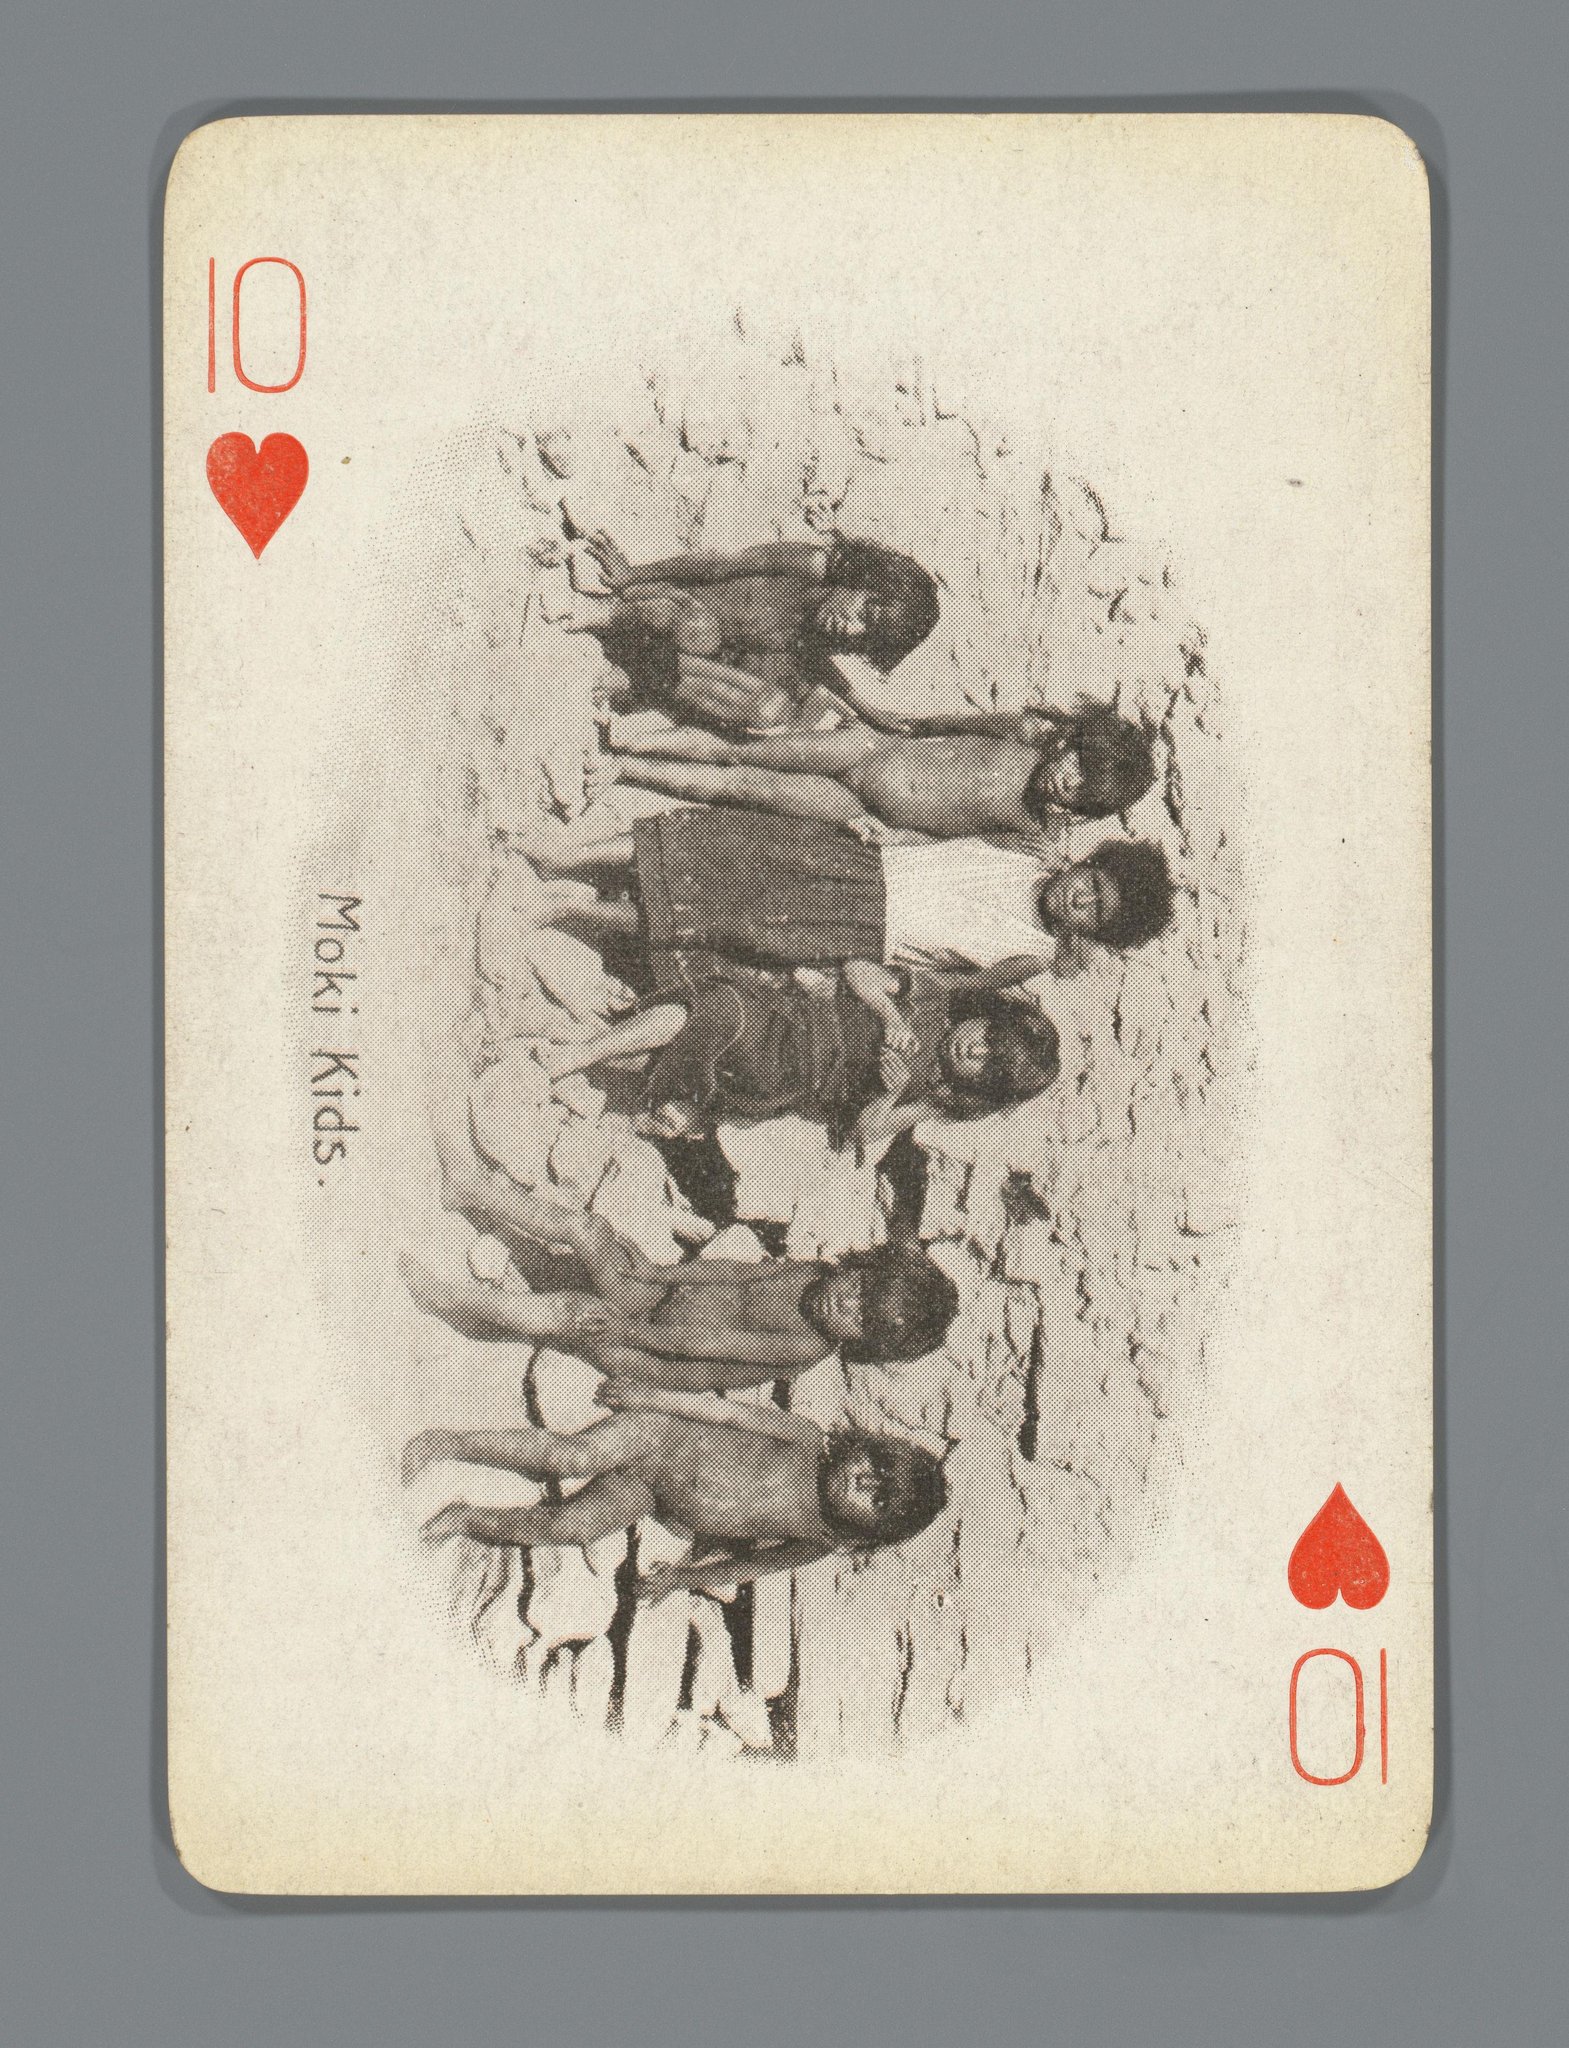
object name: playing card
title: Moki Kids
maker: adam clark vroman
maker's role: fotograaf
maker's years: 1856-1916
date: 1900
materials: paper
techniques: autotype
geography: los angeles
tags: arizona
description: Speelkaart uit doosje met 53 speelkaarten met afbeeldingen in autotypie van Native Americans. De inhoud bevat een complete set speelkaarten inclusief joker.